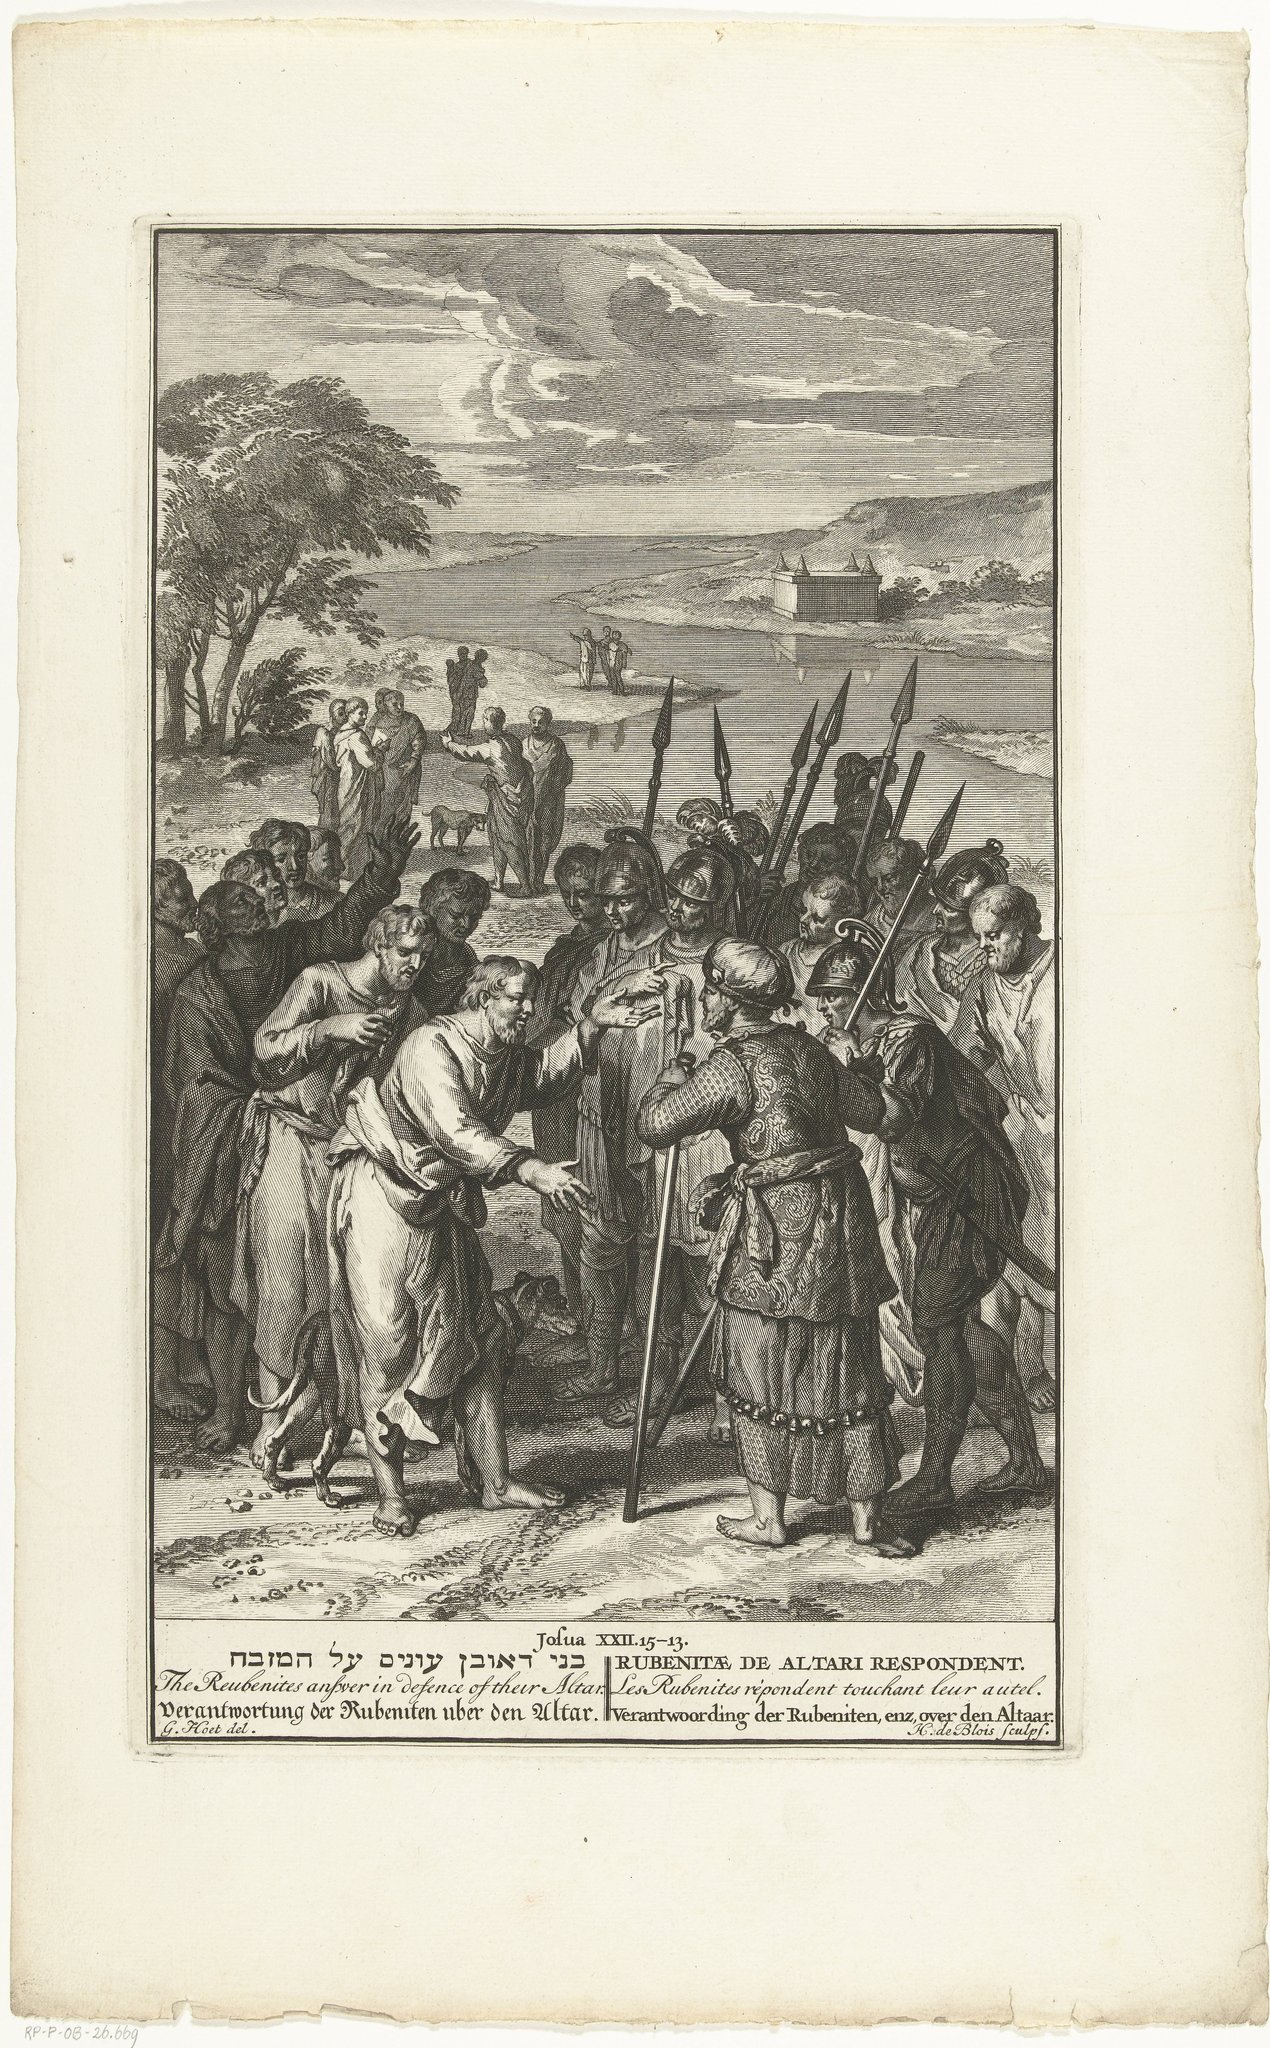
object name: book illustration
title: Verantwoording der Rubeniten, enz., over den Altaar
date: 1720-1728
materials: paper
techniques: engraving, etching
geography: the hague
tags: an agreement is reached: the altar built at the borders of the jordan is only an altar of testimony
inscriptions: collector's mark: Lugt 2228, inscription: ‘utrechts Fundatie huijs’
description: Prent gemaakt voor: Figures de la Bible. Amsterdam, Bernard Picart, 1720. Prent ook gebruikt in: Taferelen der voornaamste geschiedenissen van het Oude en Nieuwe Testament (...) door de vermaarde kunstenaars Hoet, Houbraken, en Picart getekent (...) en met beschrijvingen uitgebreid. Den Haag: Pieter de Hondt, 1728.